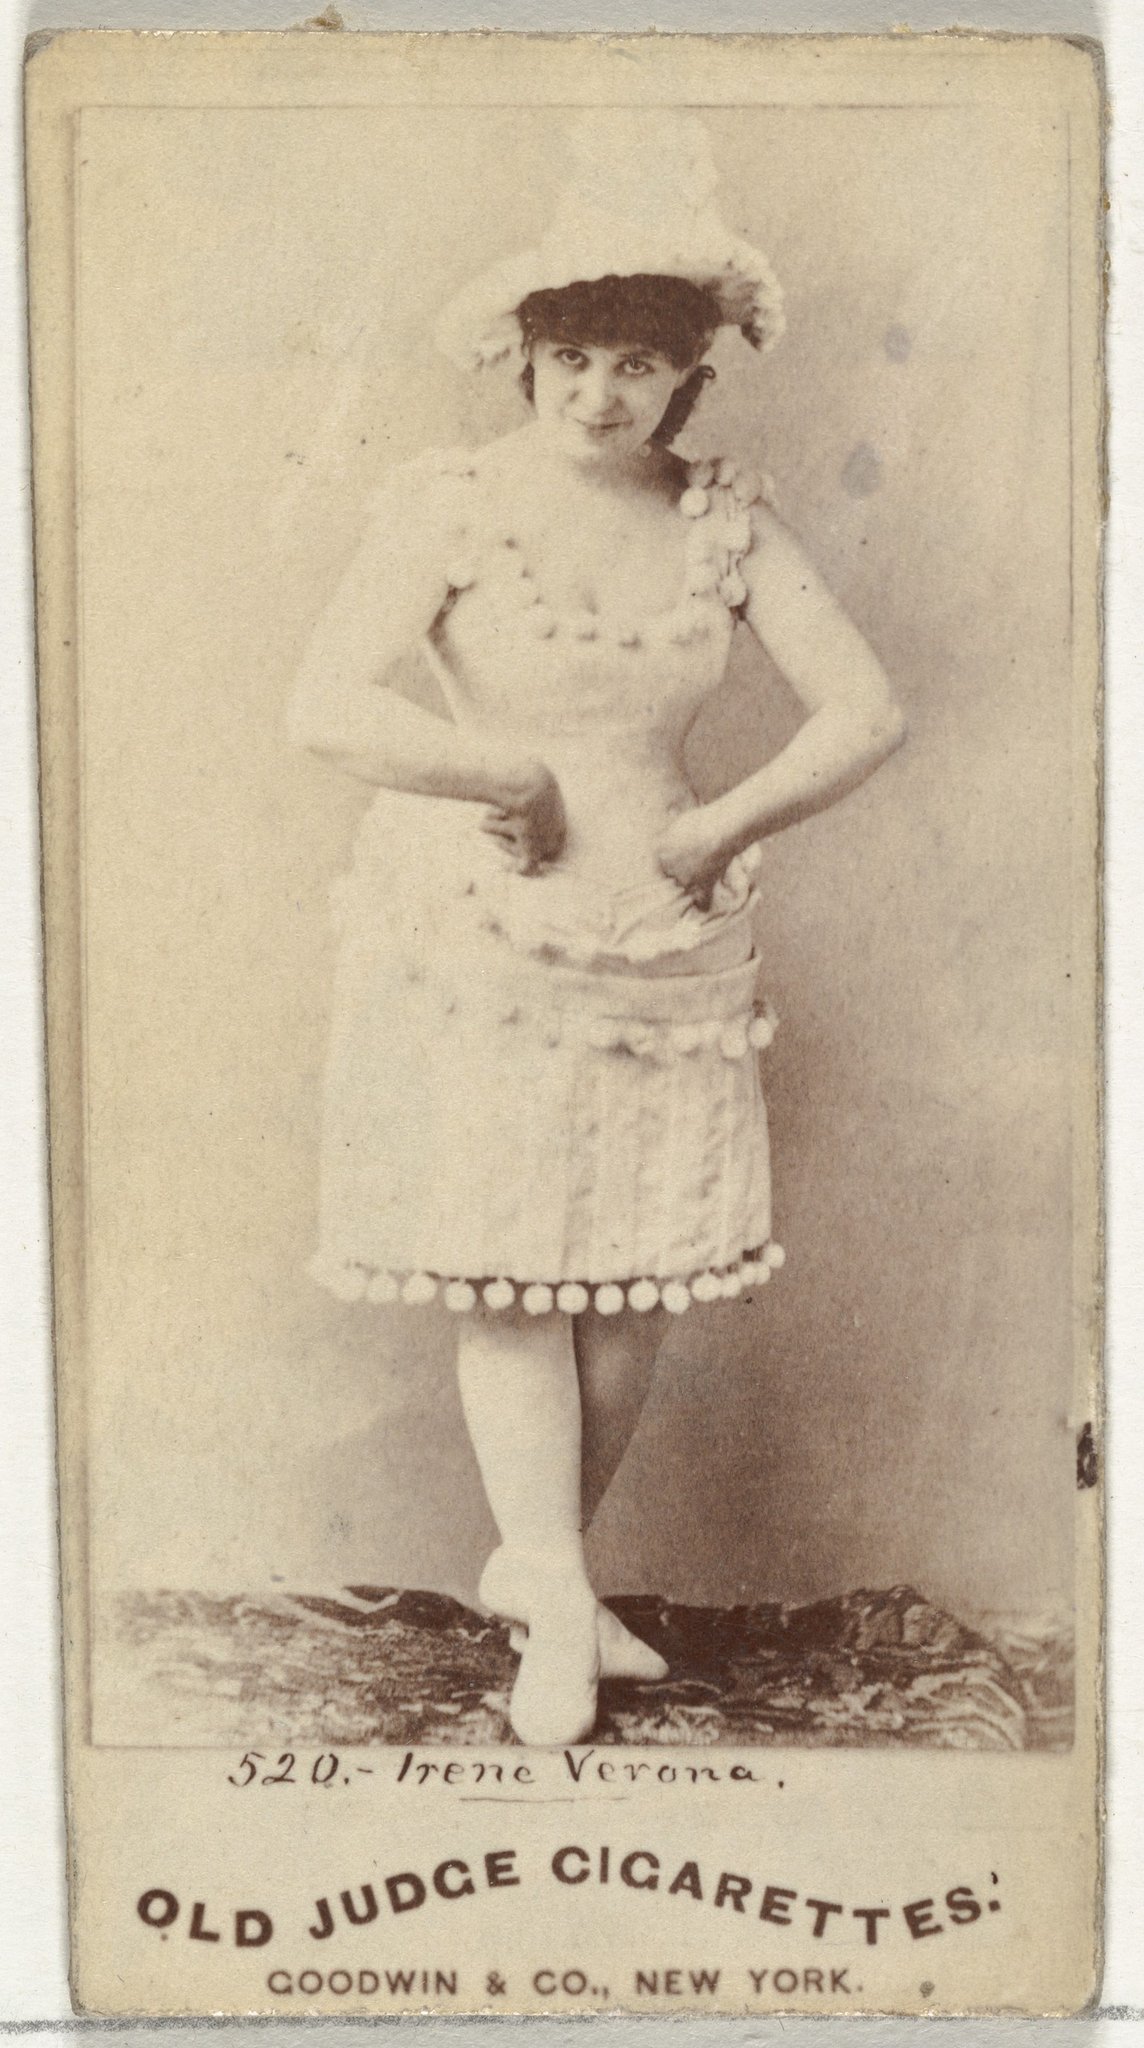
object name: photograph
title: Irene Verona, from the Actors and Actresses series (N171) for Old Judge Cigarettes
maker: goodwin & company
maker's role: publisher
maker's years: 1850-1950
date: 1886-1890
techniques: albumen silver print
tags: portraits,women,actresses